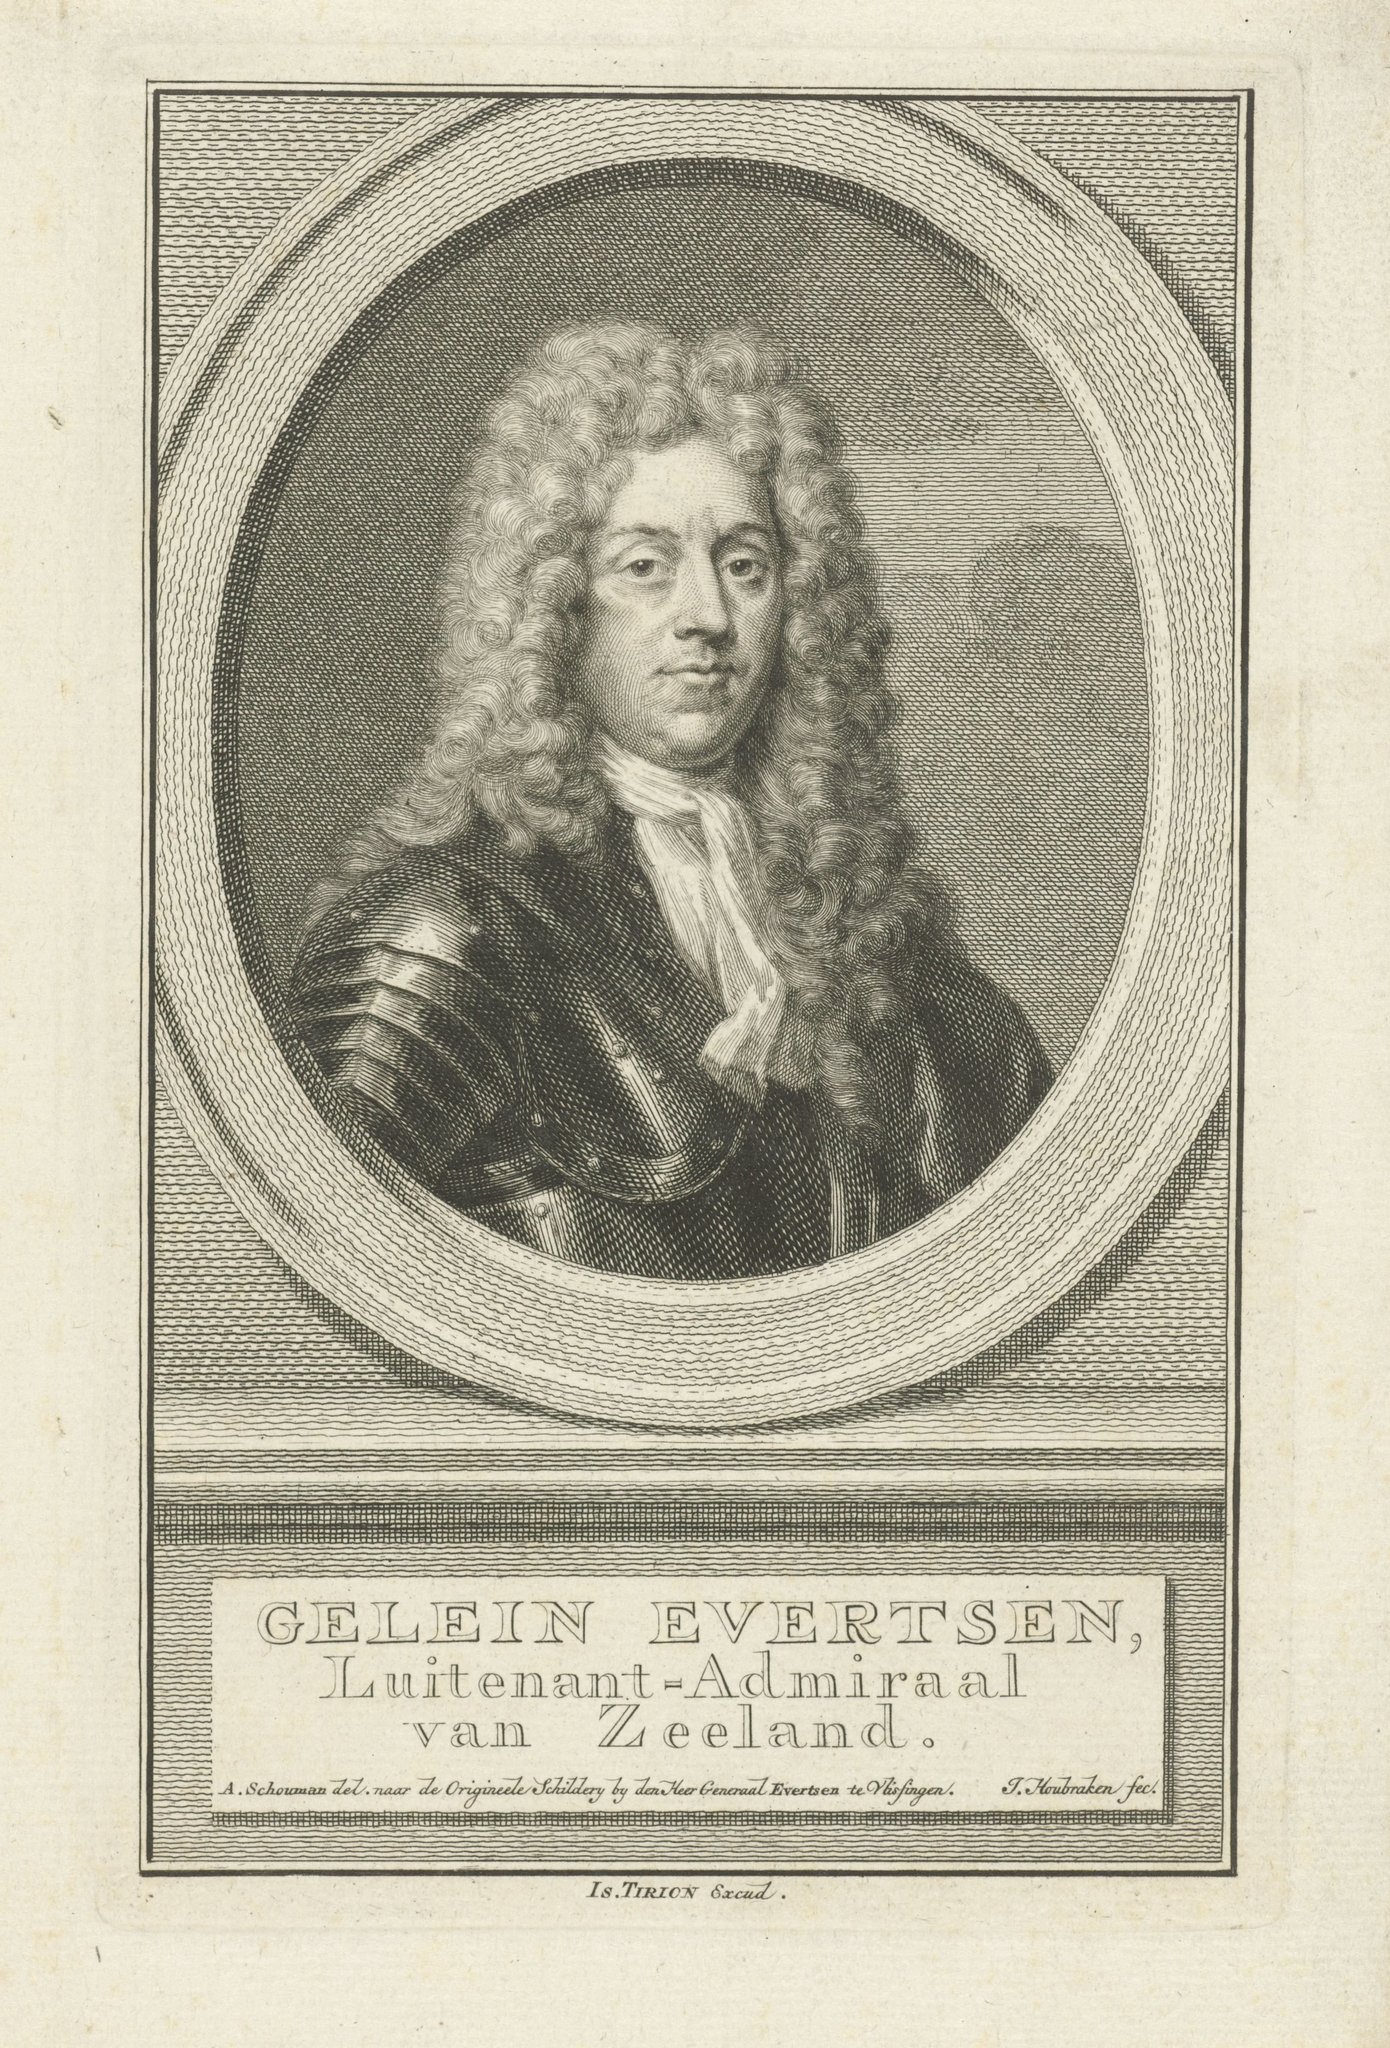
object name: print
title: Portret van Geleyn Evertsen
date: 1749-1759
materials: paper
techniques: engraving, etching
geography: amsterdam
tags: geleyn evertsen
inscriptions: collector's mark: Lugt 2228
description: Prent ook gebruikt in: Jan Wagenaar, Vaderlandsche historie, vervattende de geschiedenissen der nu Vereenigde Nederlanden, inzonderheid die van Holland (...), 21 delen. Amsterdam, Isaak Tirion, 1749-59. Prent volgens Ver Huell ook gebruikt in: Portraiten van eenige der vermaardste staatsmannen en zeehelden, als toevoeging op: Willem Tiberius Hattinga, Atlas van Zeeland. Amsterdam: Isaak Tirion, 1760.